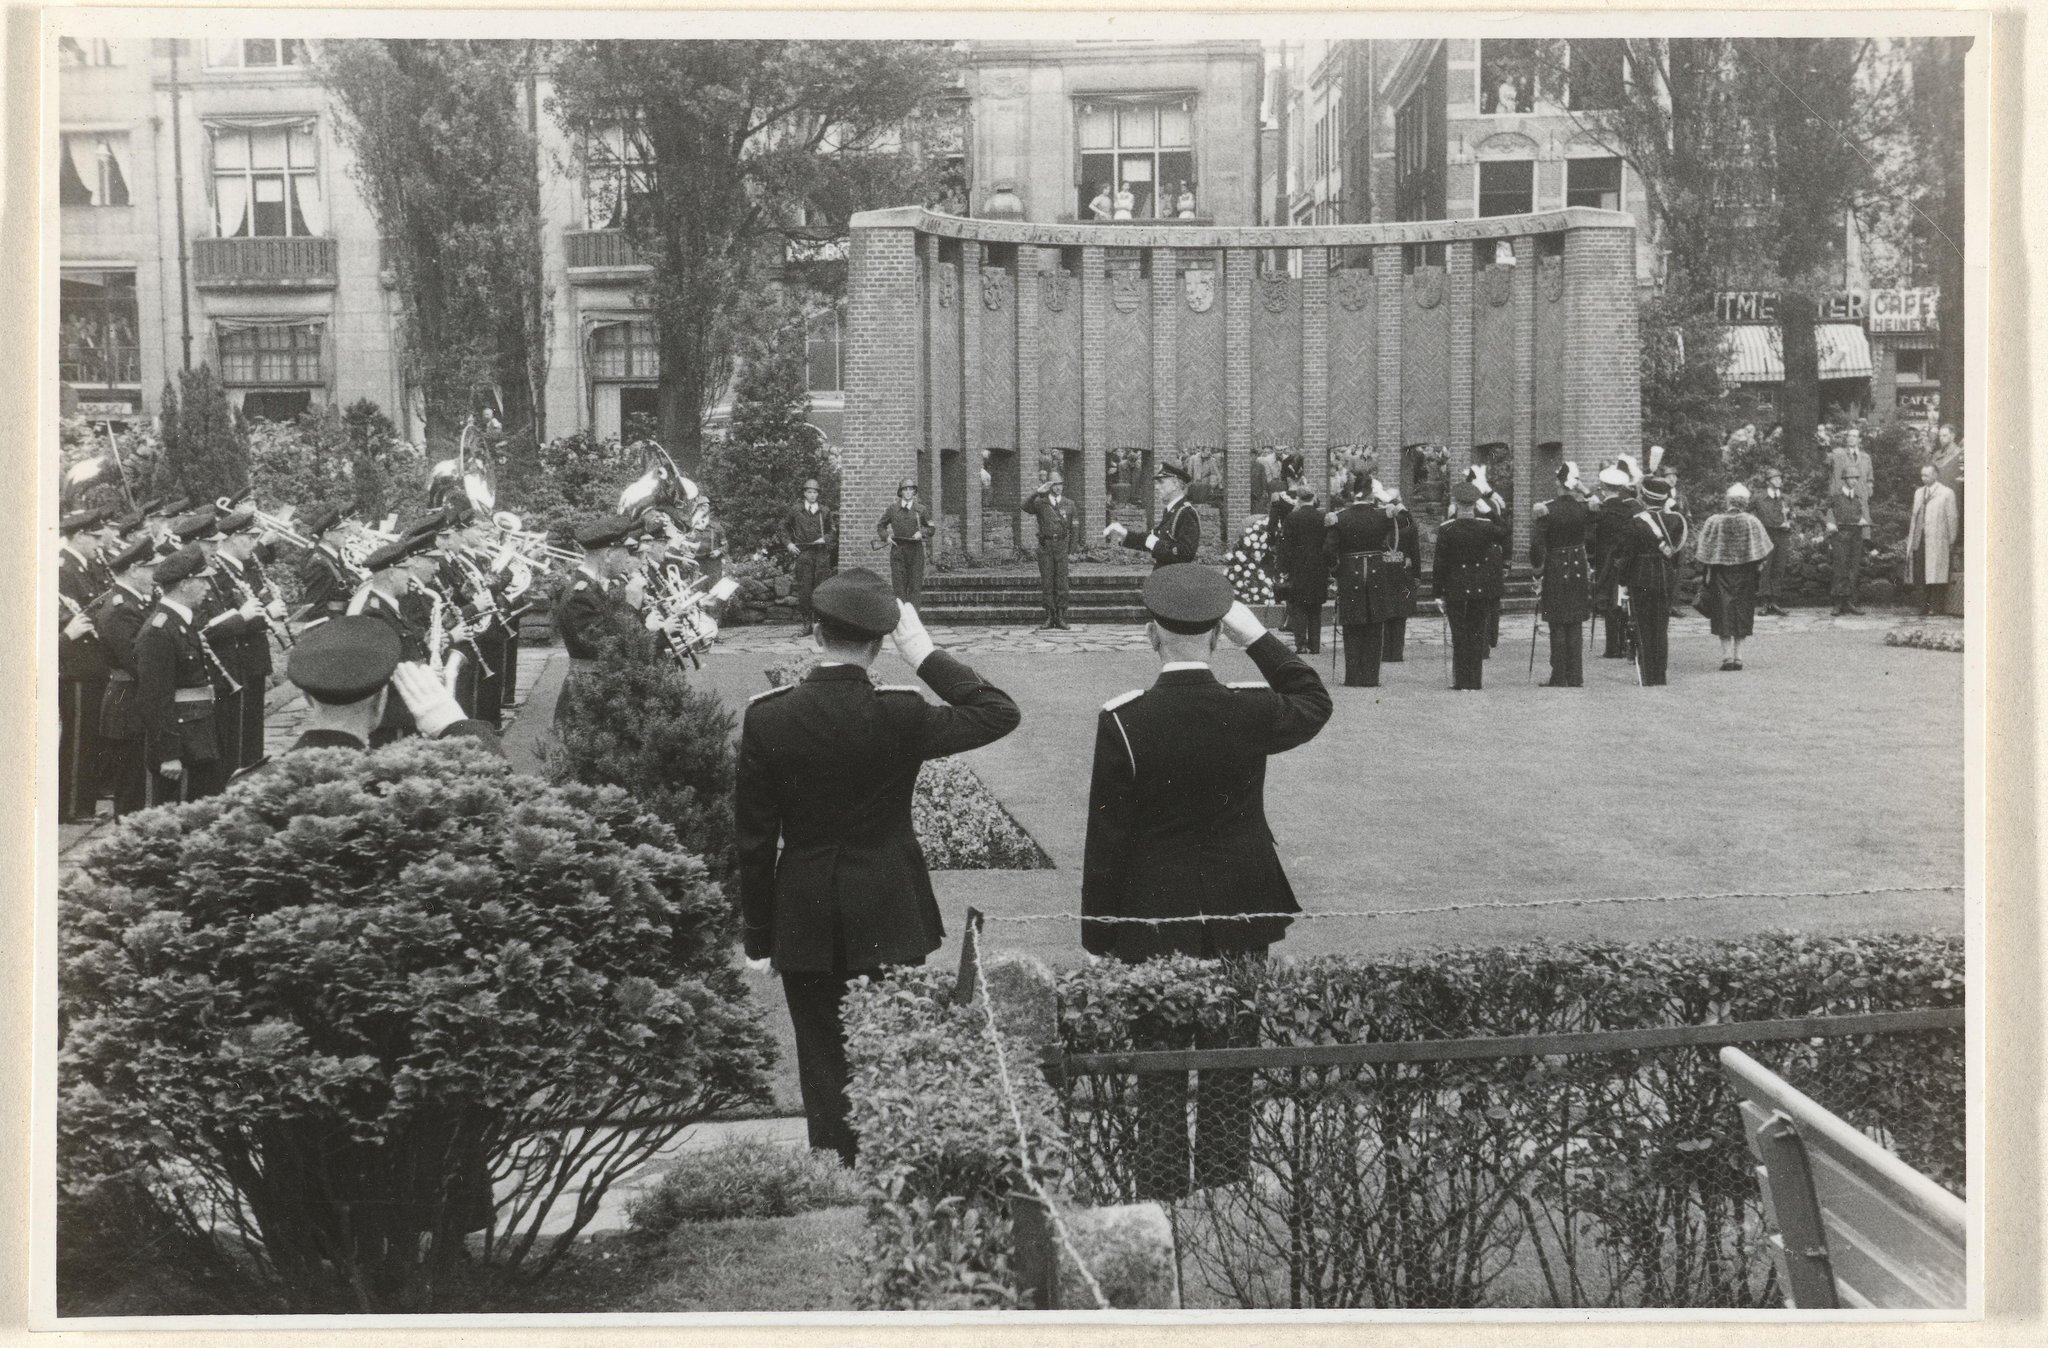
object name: photograph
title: Marine muziekgezelschap bij een oorlogsmonument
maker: Anonymous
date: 1954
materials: photographic support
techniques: gelatin silver print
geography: amsterdam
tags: musical instruments; group of musical instruments, making music; musician with instrument, other memorial structures